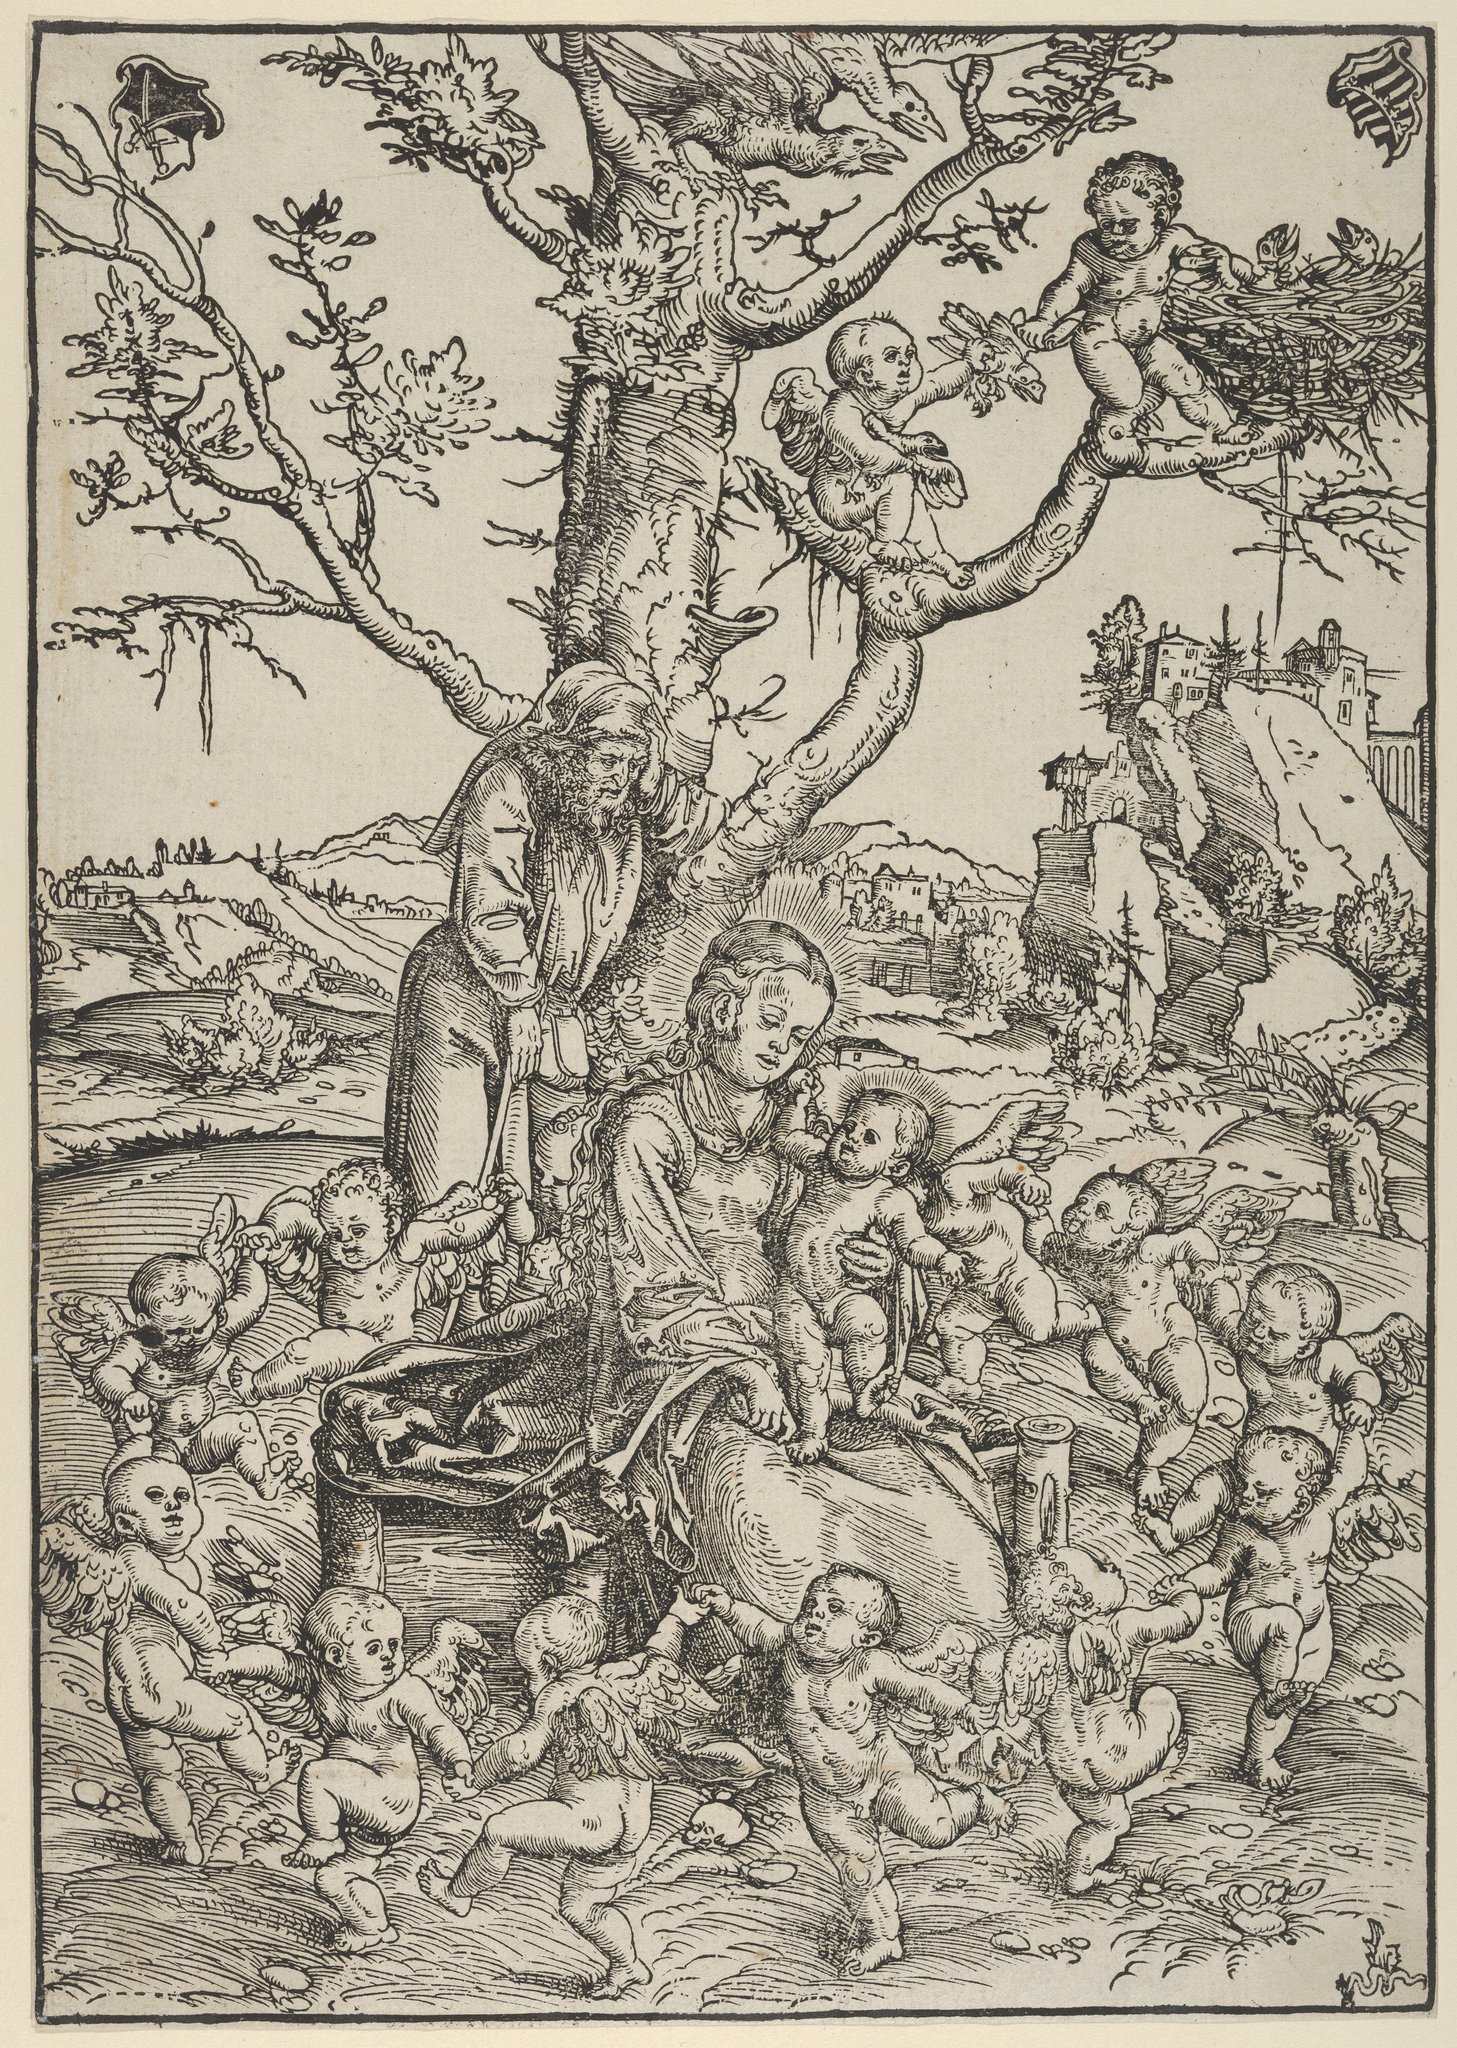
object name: print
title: The Rest on the Flight to Egypt, with Dancing Angels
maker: lucas cranach the elder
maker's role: artist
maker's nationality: german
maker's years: 1472-1553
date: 1472-1553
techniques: woodcut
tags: infants,men,women,dancing,angels